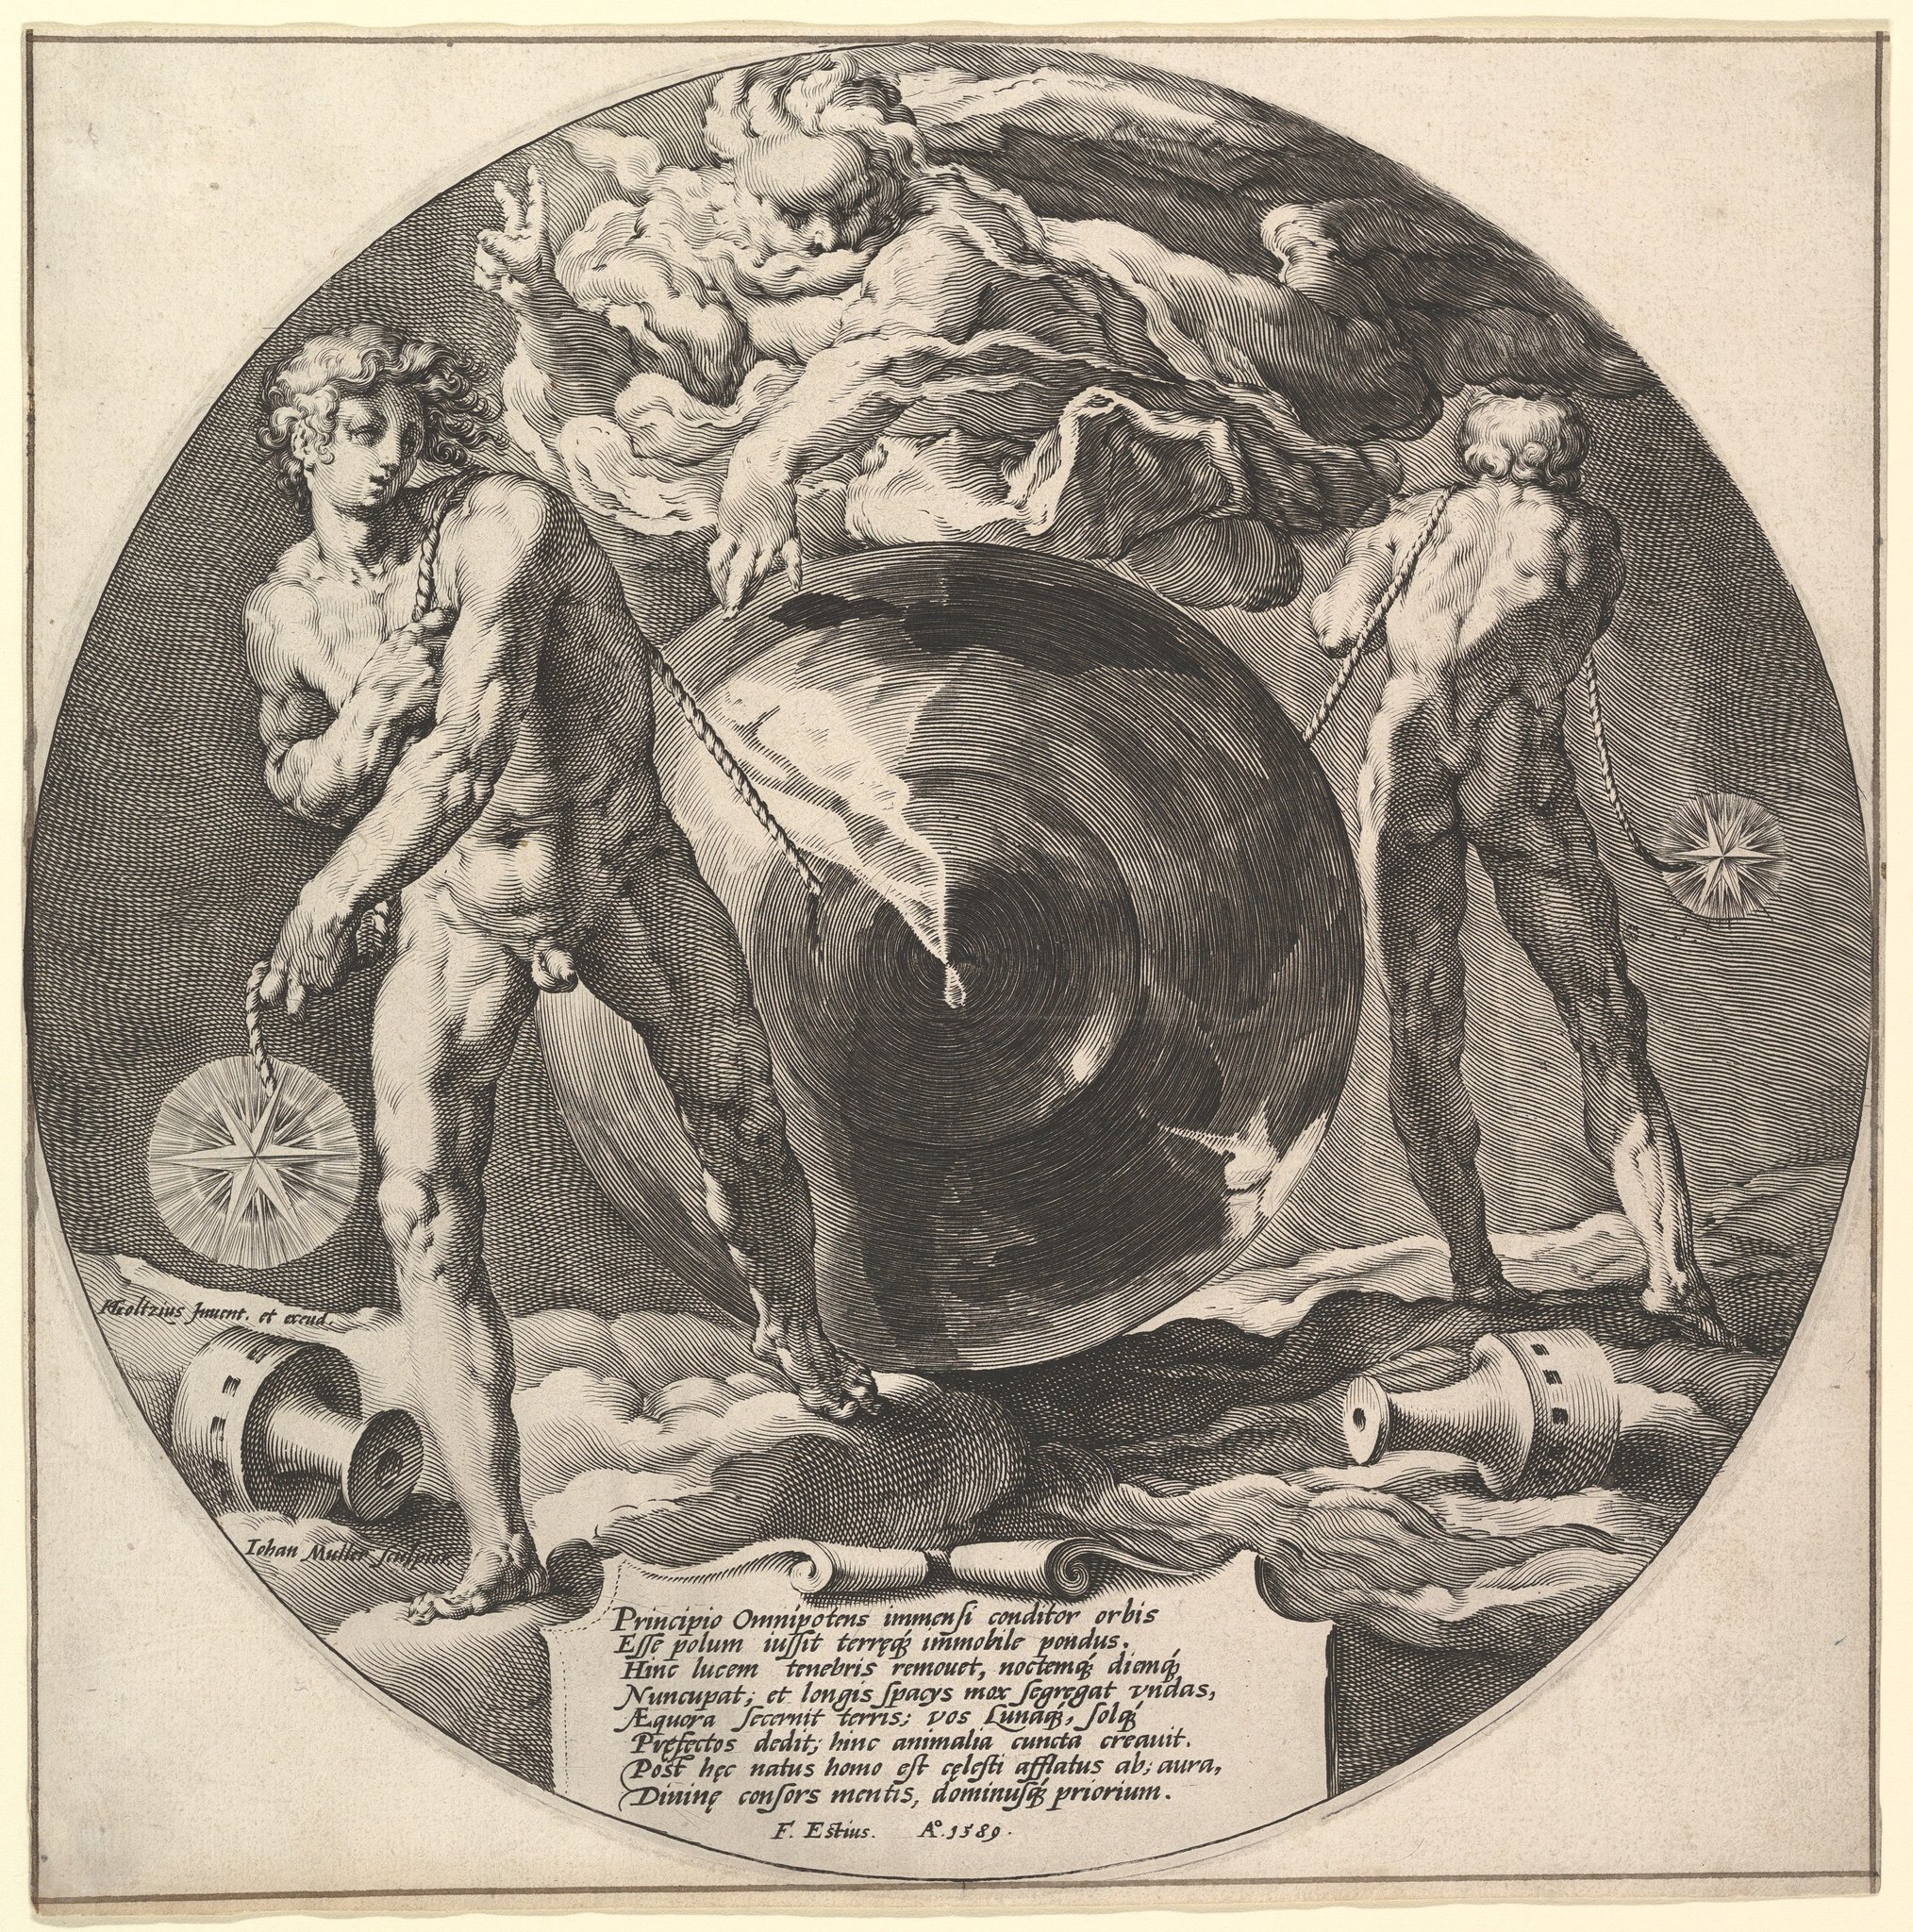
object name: print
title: God Creating Heaven and Earth, title page from "The Creation of the World"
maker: jan muller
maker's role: artist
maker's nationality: netherlandish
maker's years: 1571-1628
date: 1589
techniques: engraving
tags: male nudes